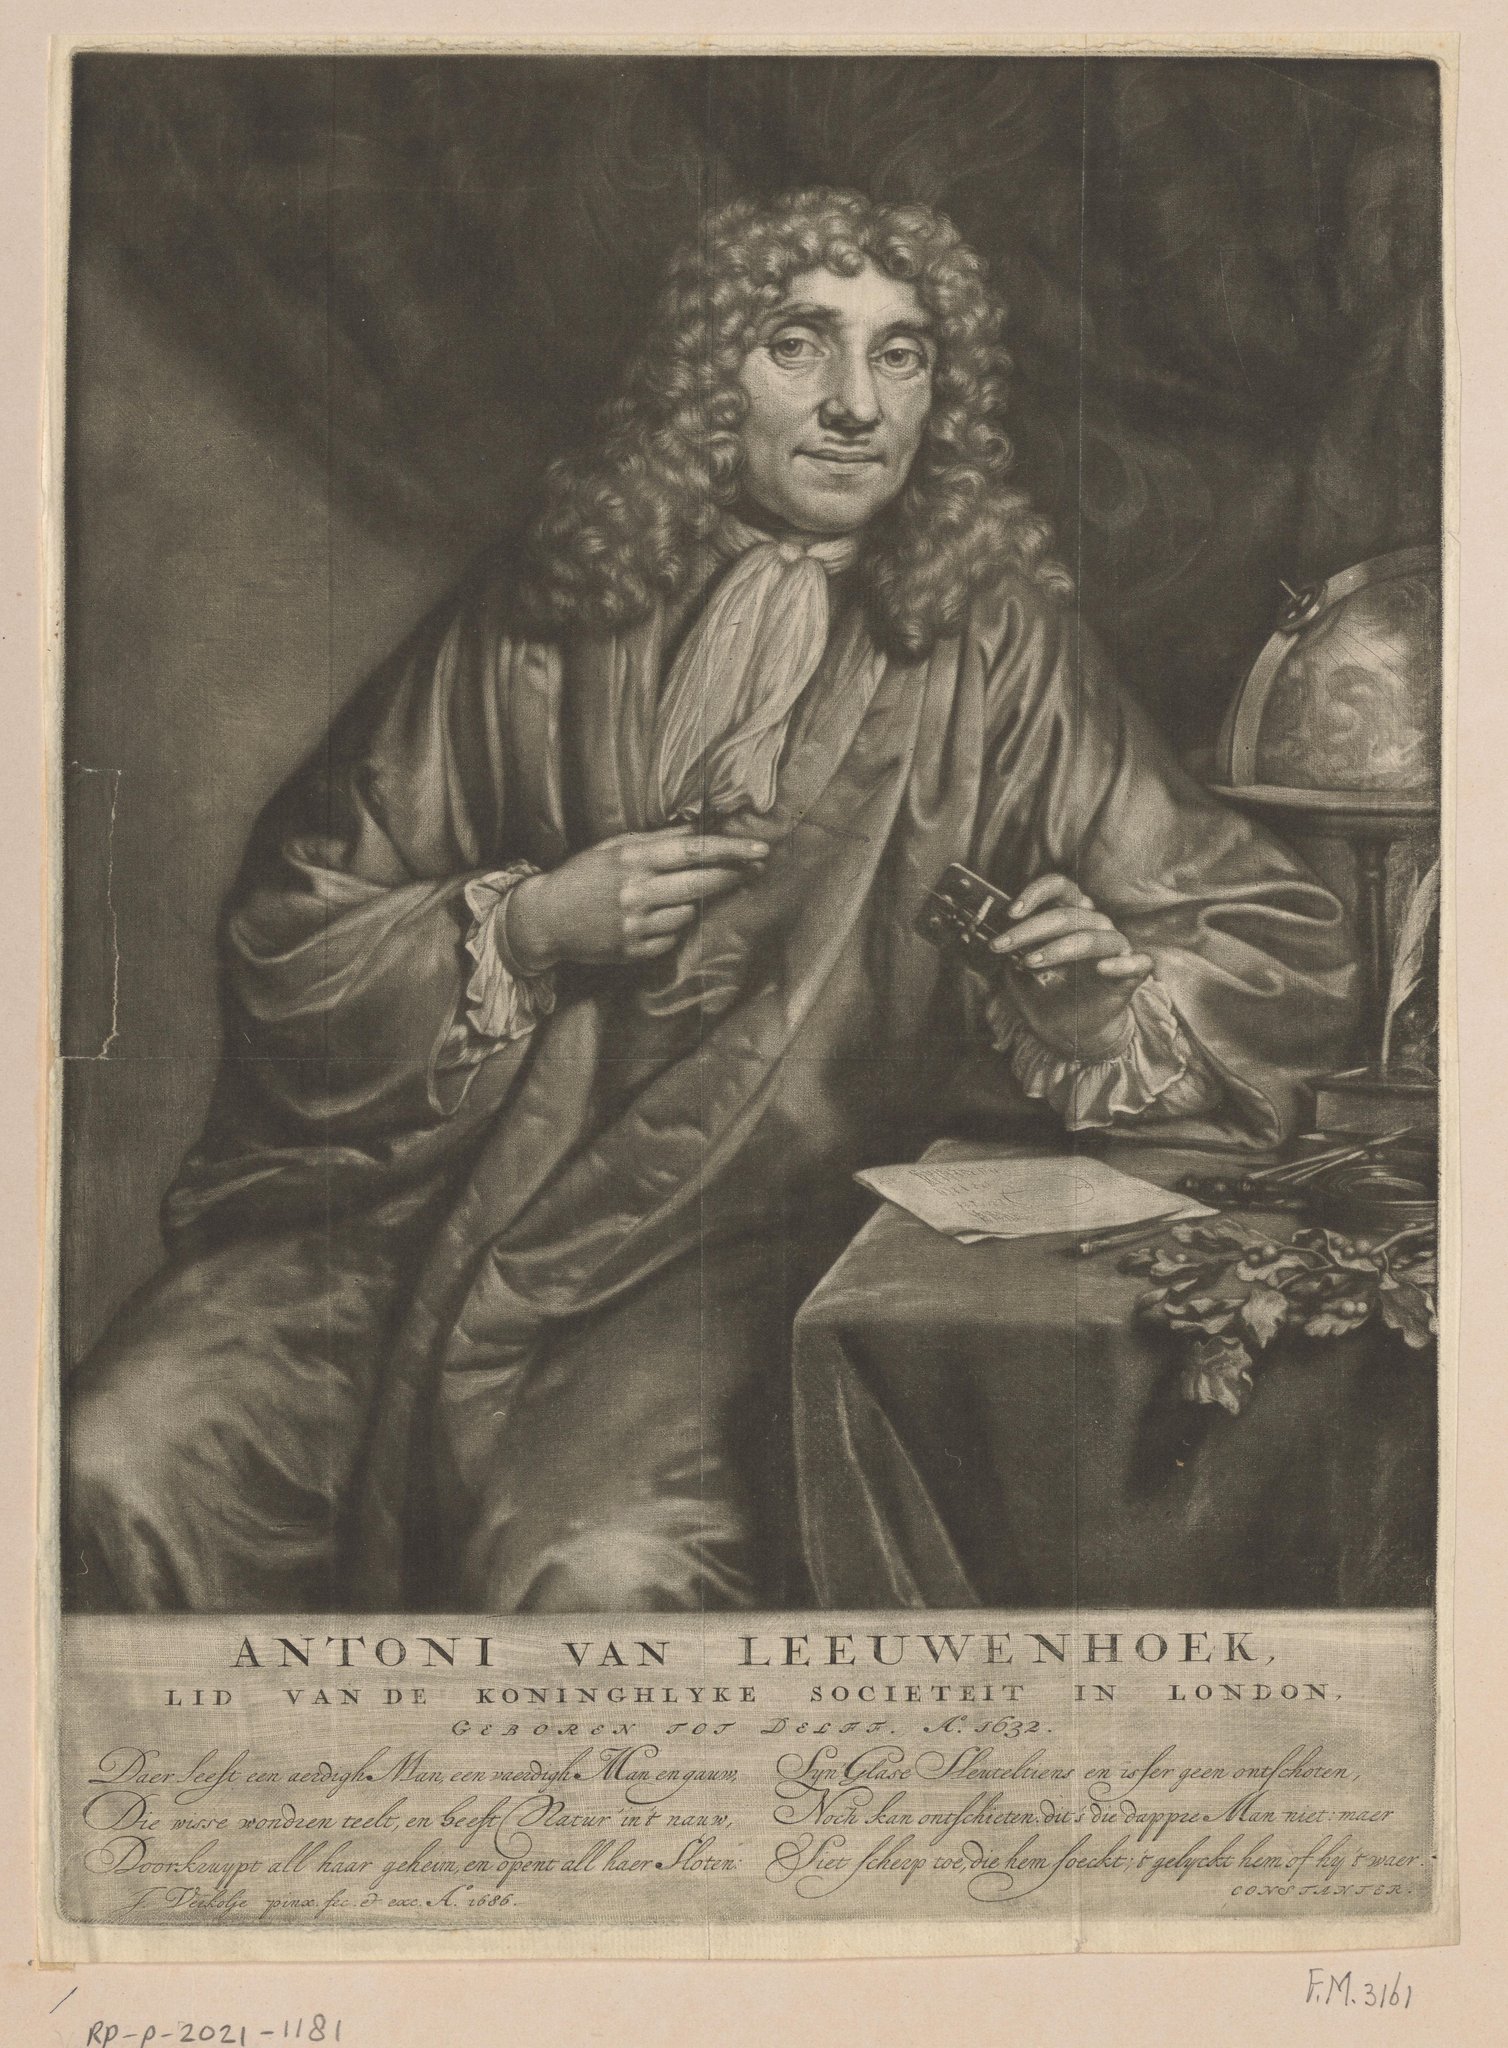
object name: print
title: Portret van Anthony van Leeuwenhoek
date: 1686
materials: paper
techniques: mezzotint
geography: amsterdam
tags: delft, physicist, anthony van leeuwenhoek, writing tools, historical persons, compasses, magnifying glass, biology (+ portrait of scholar, scientist), science and technology (+ portrait of scholar, scientist), globe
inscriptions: date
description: Met zesregelig lofdicht in het Nederlands in twee kolommen. Van Leeuwenhoek zit aan een tafel waarop een globe staat en meetinstrumenten liggen. In zijn hand houdt hij zijn microscoop.